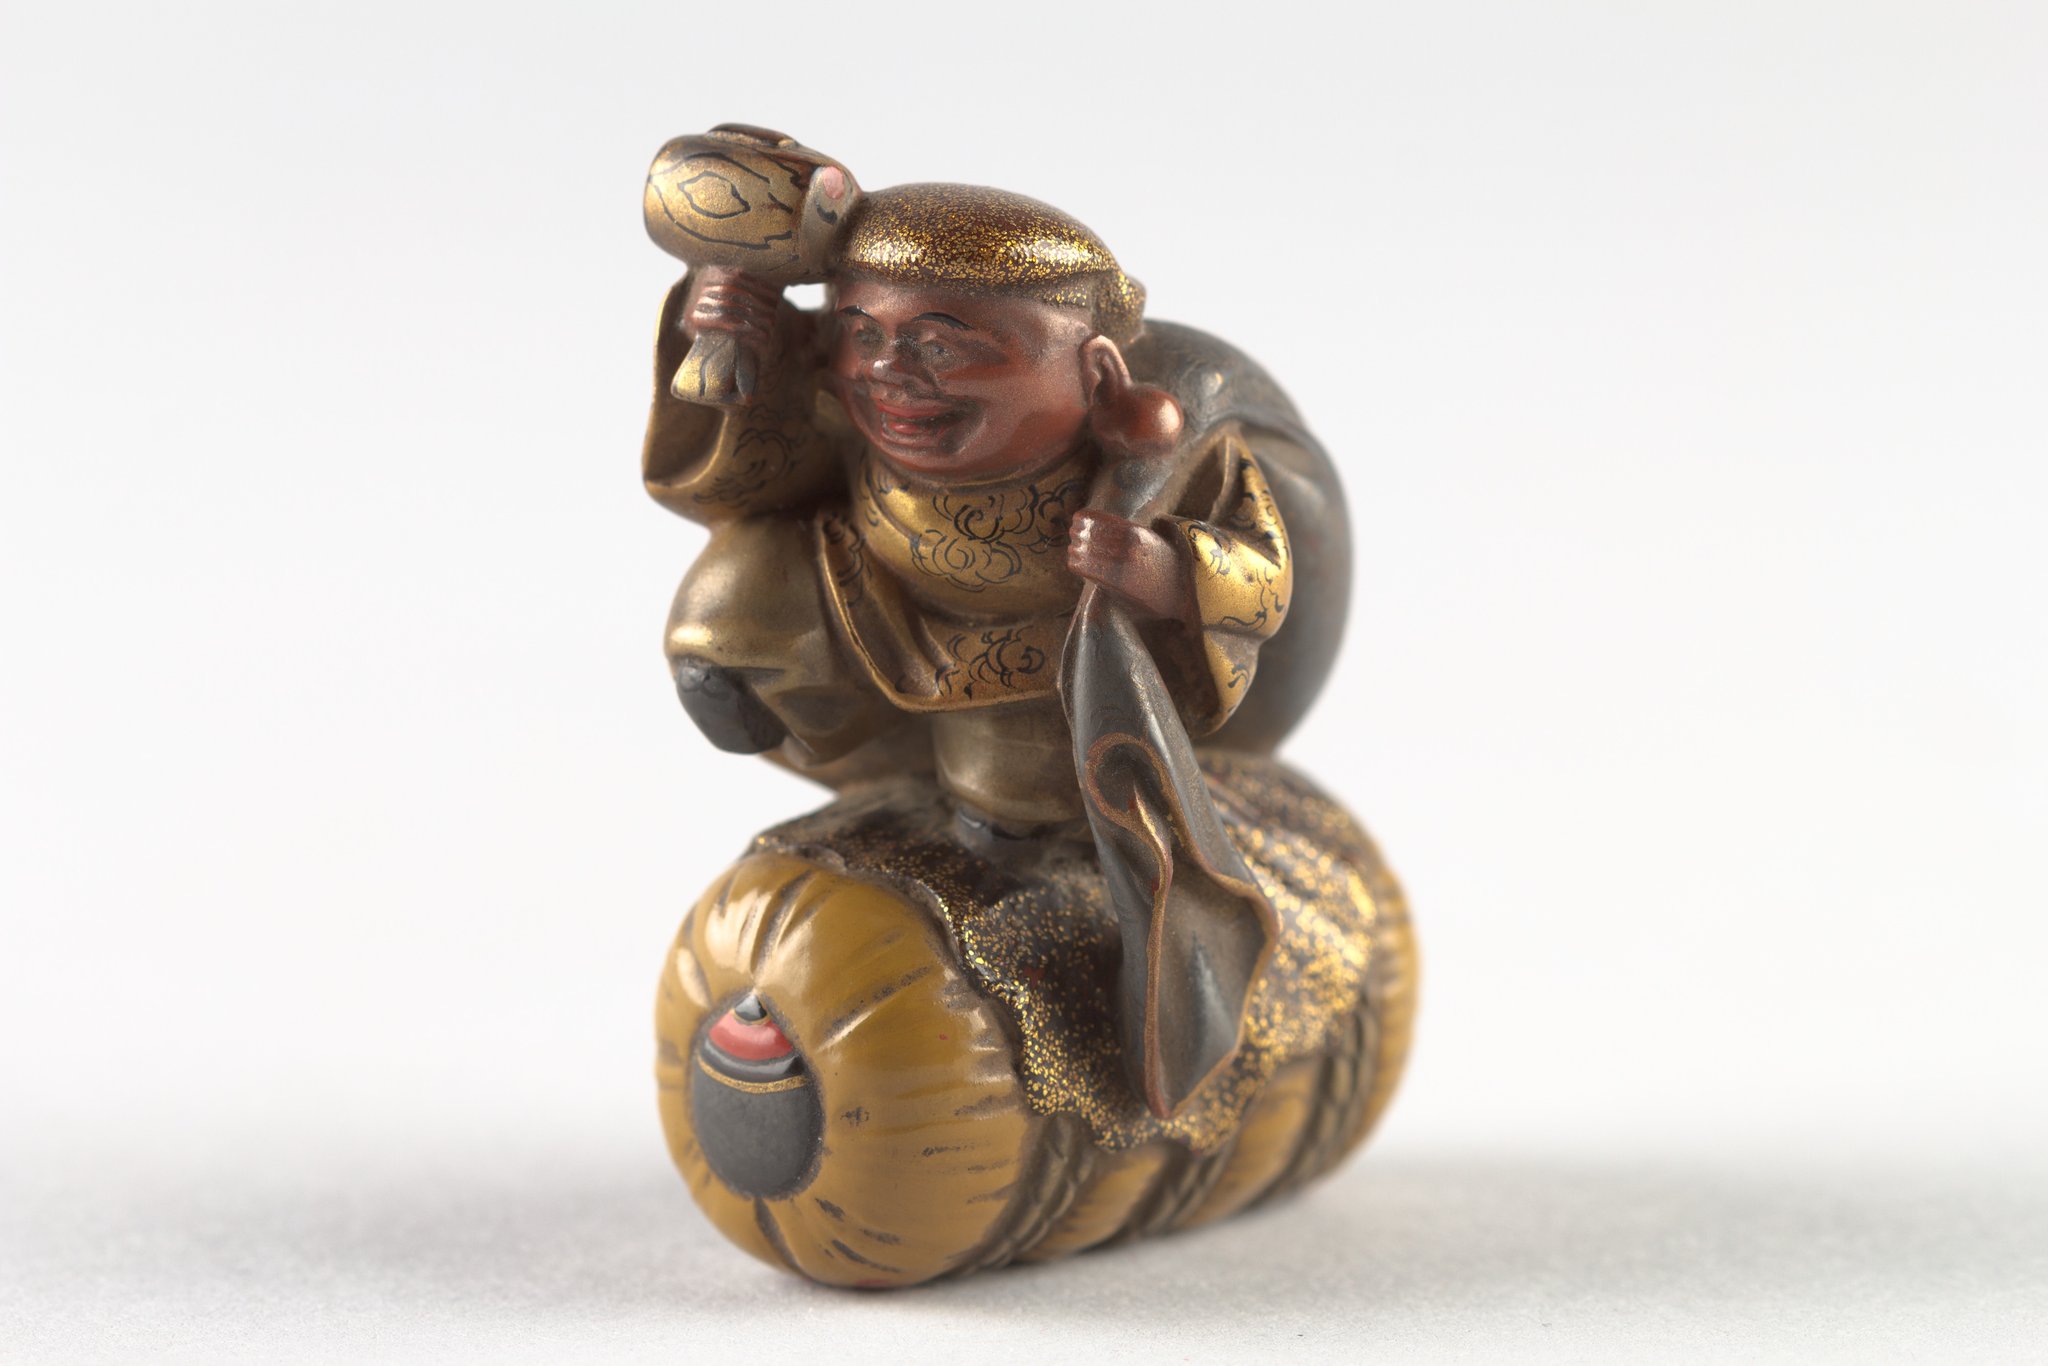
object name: netsuke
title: Netsuke of Daikoku and Bag on Rice Bale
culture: japanese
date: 1801-1900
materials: wood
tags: men